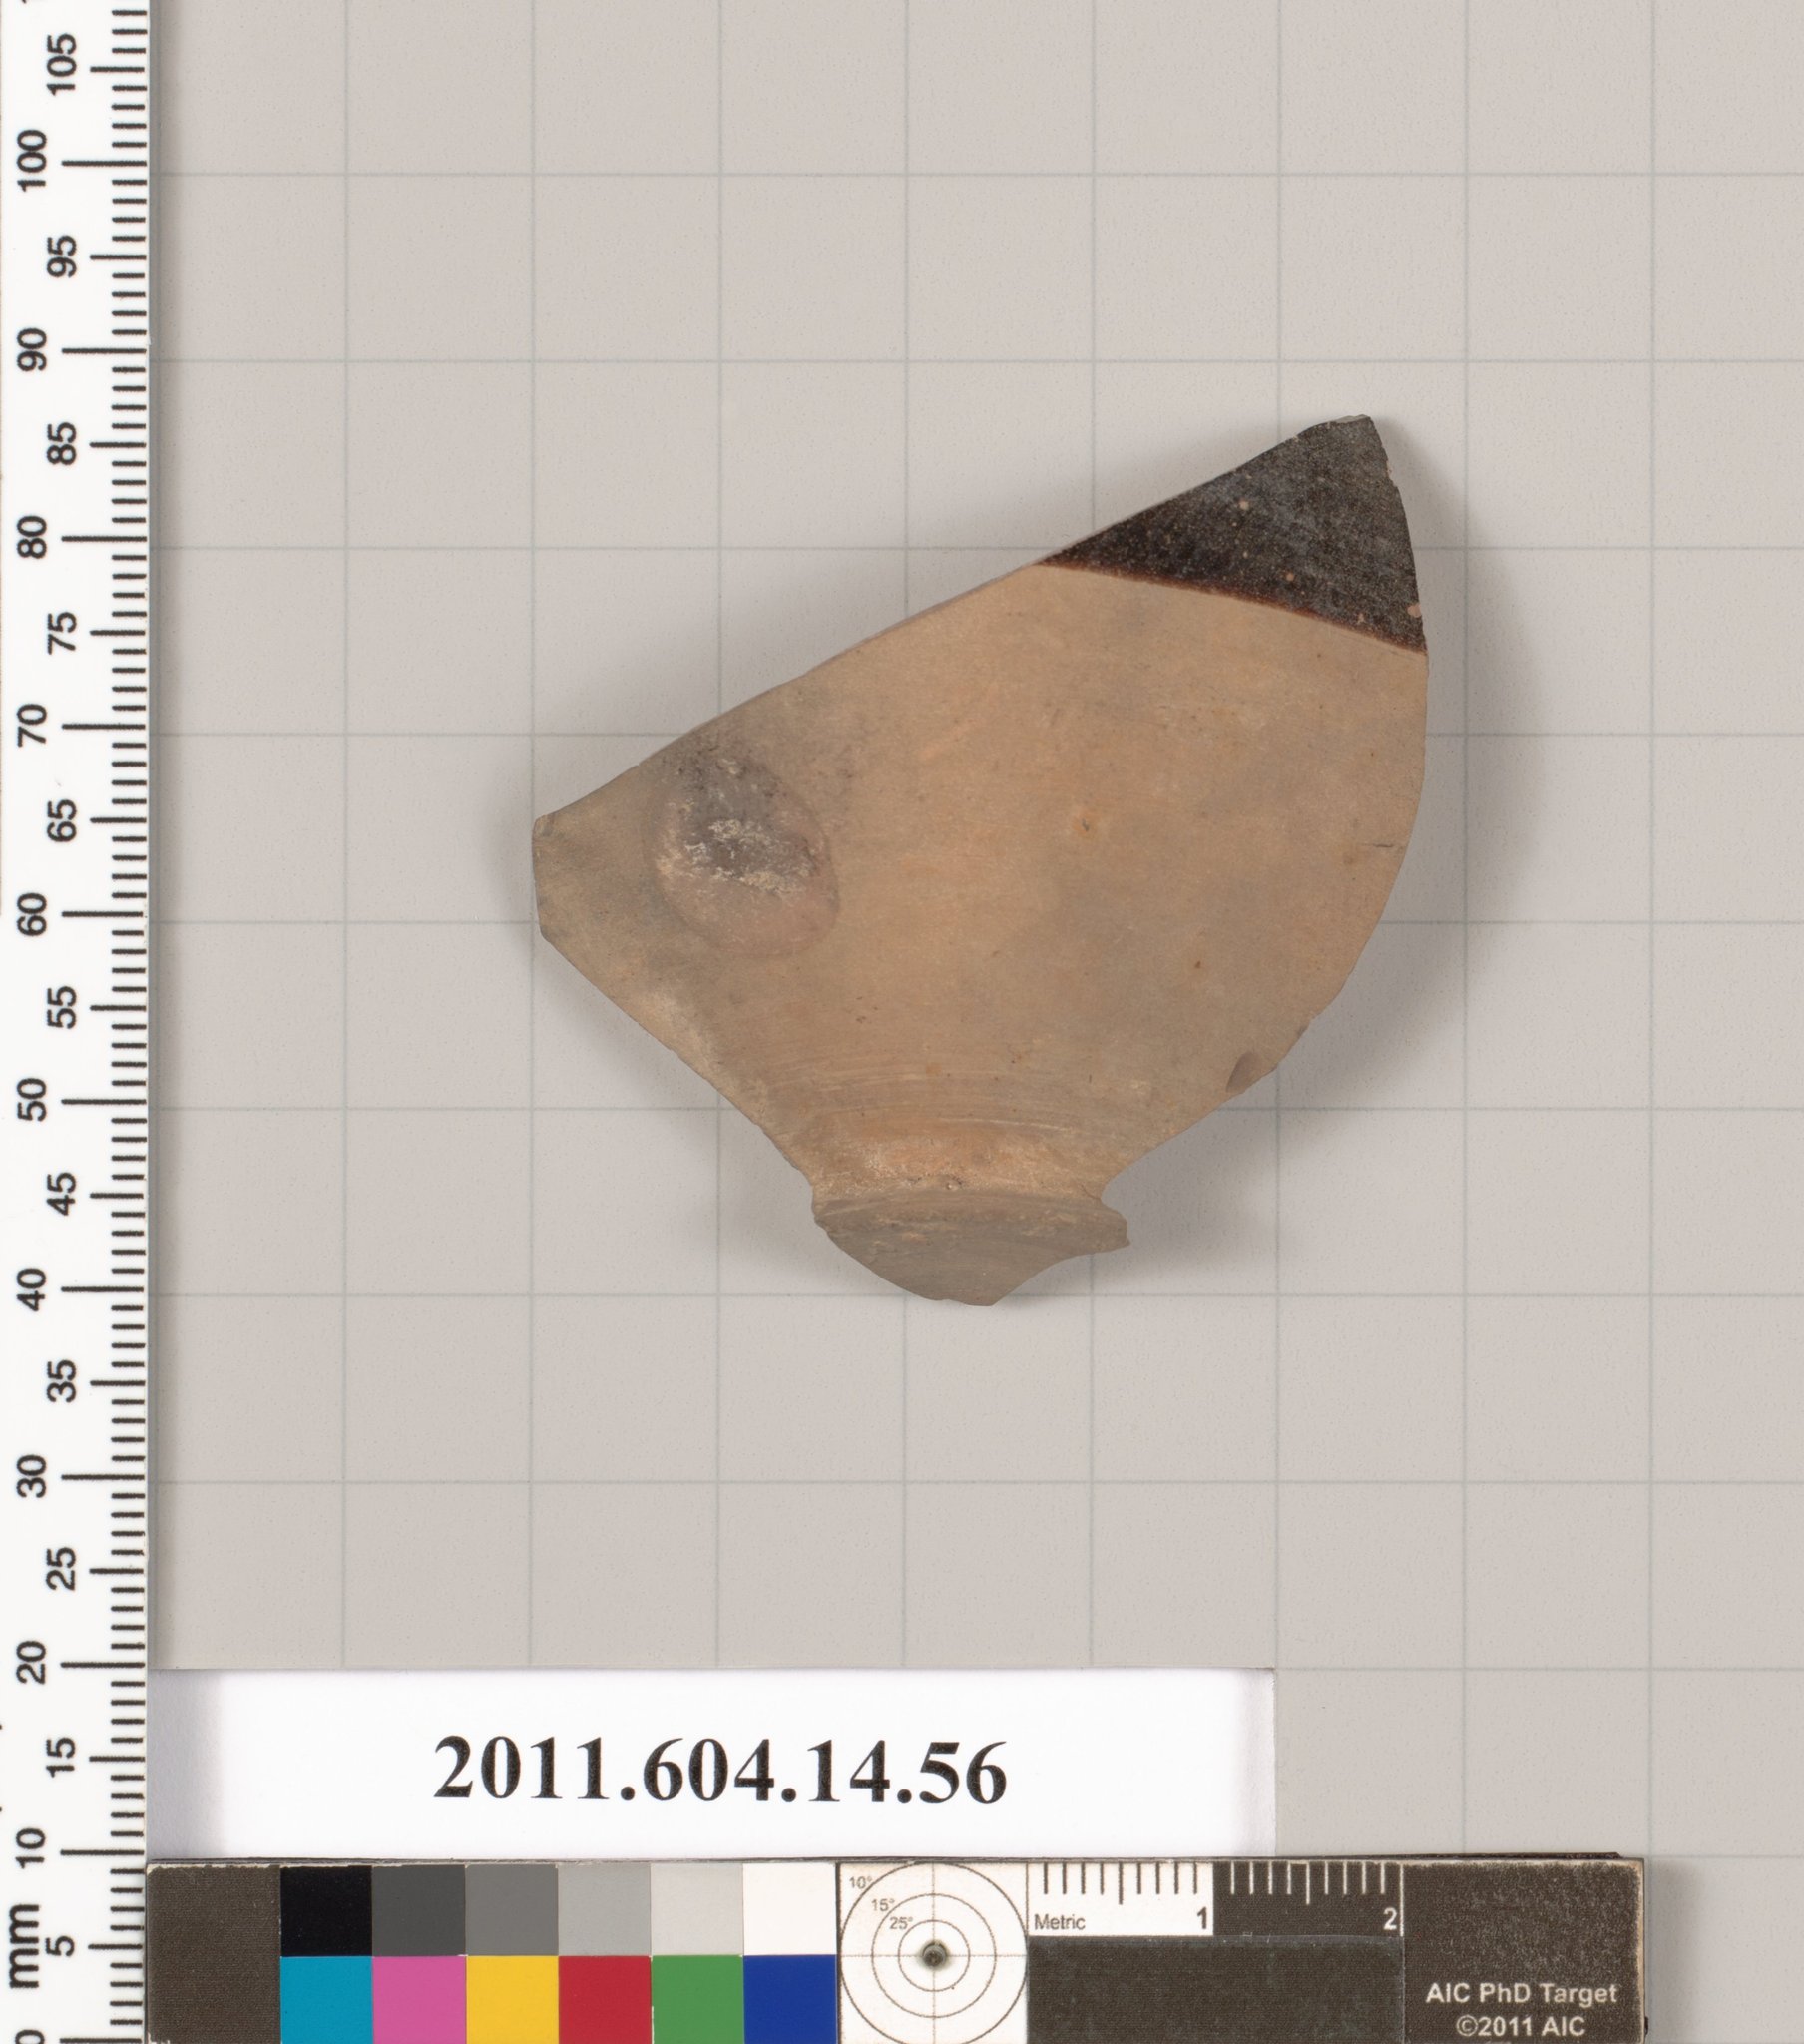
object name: undetermined closed shape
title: Terracotta fragment of a closed shape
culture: unknown fabric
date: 600-301 BCE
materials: terracotta